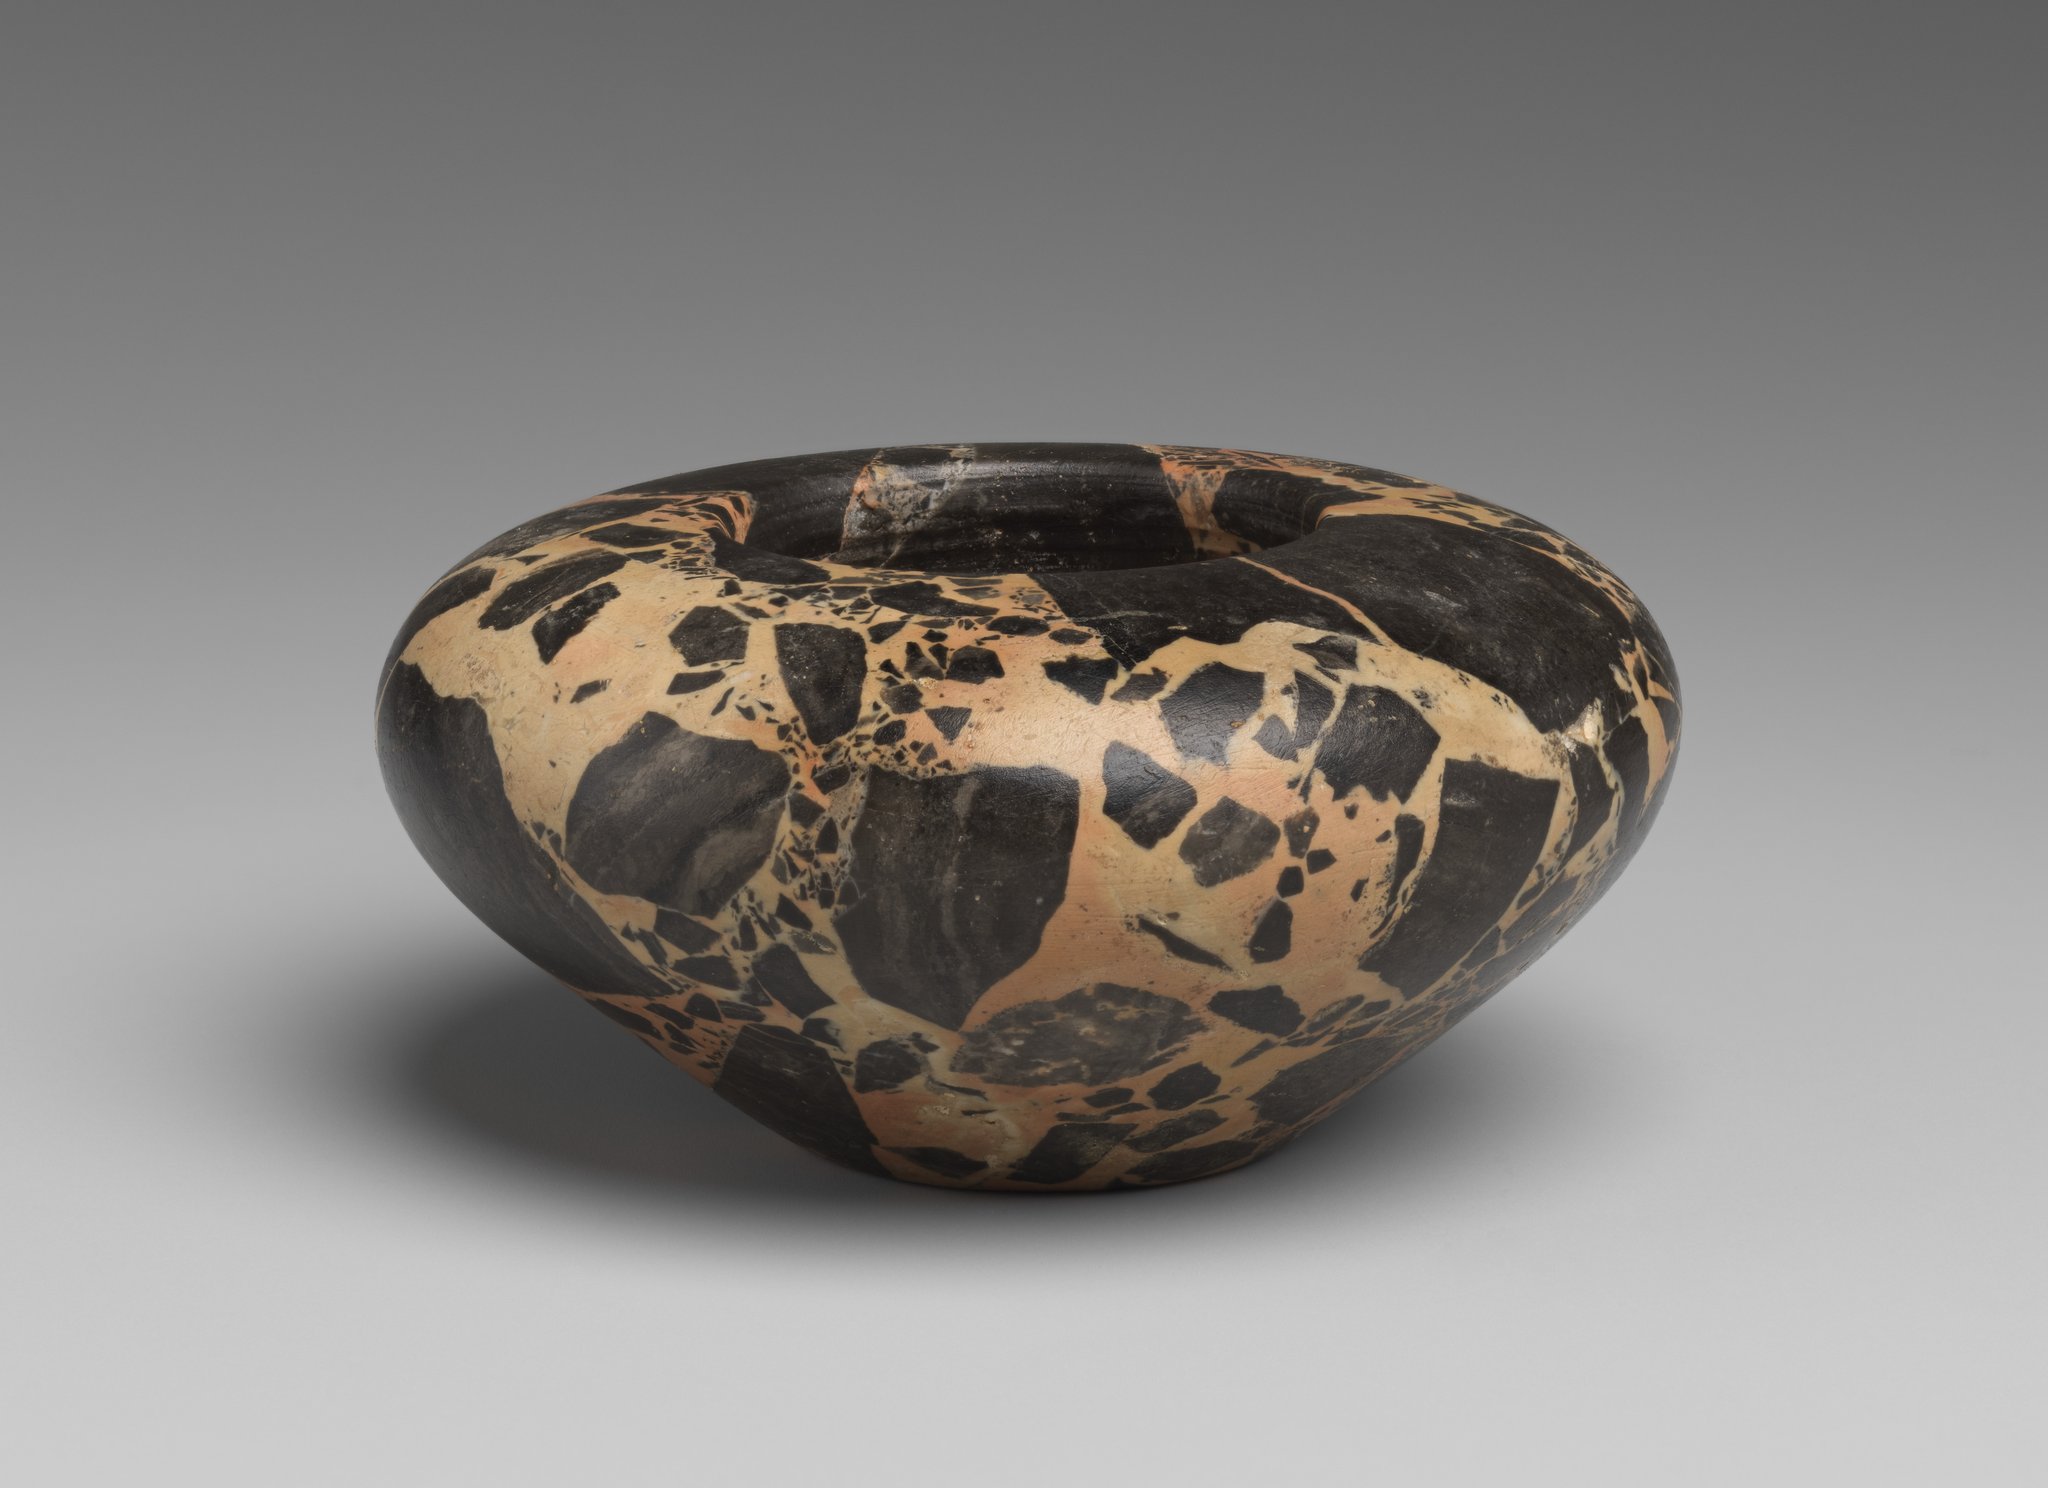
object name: bowl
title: Breccia bird's-nest bowl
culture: minoan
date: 1800-1700 BCE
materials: marble